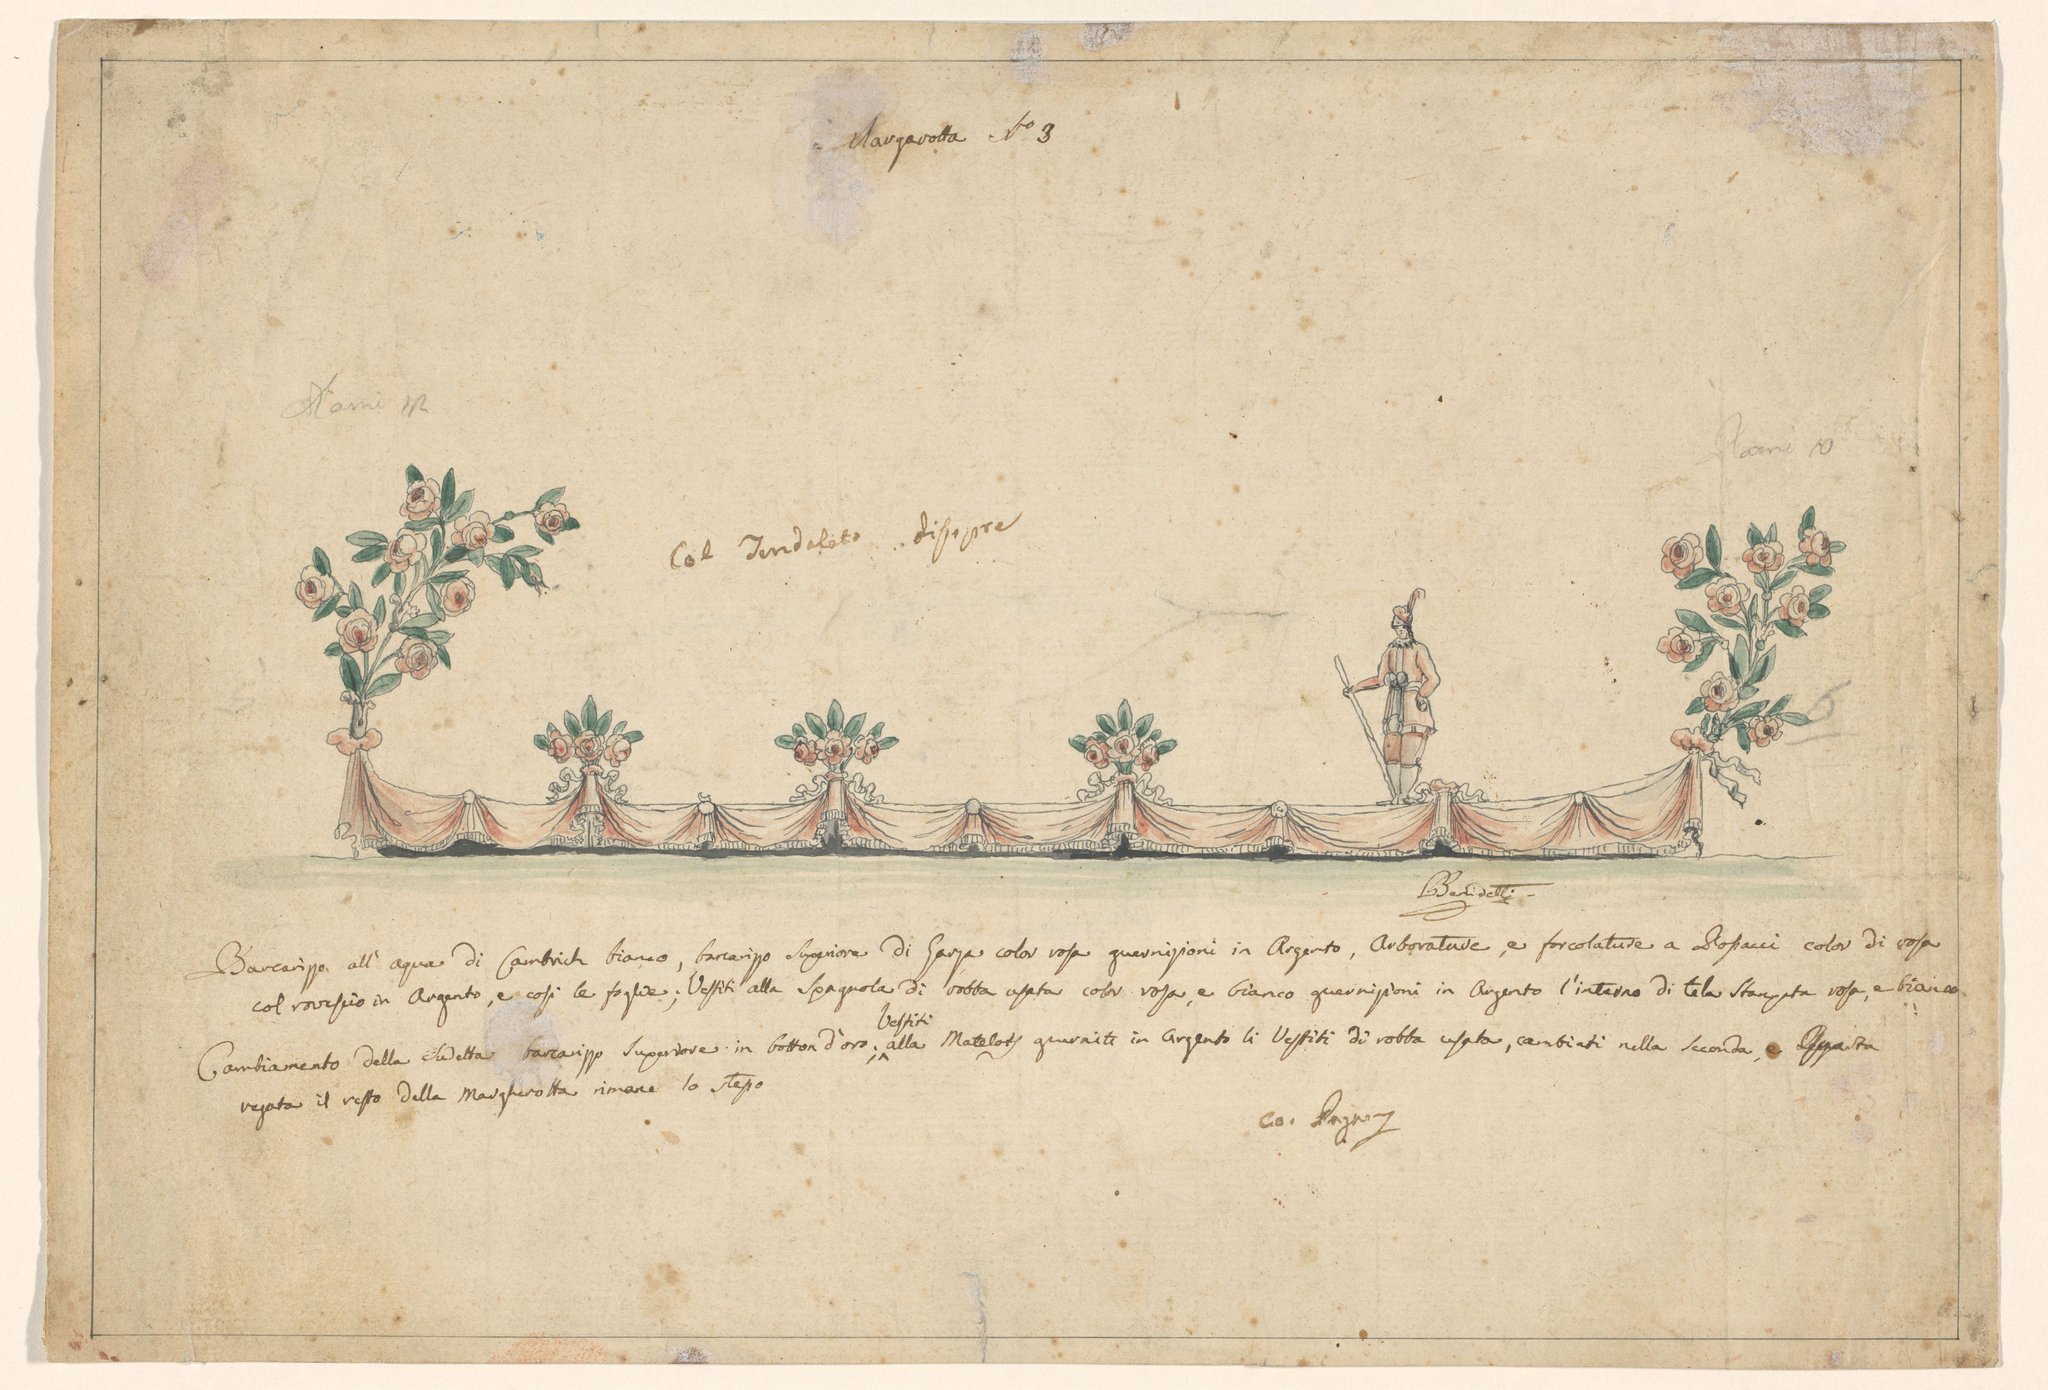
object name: print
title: Portret van Nicolas de La Fauconnière de Catinat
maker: Anonymous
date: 1667-1749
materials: paper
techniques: engraving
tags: historical persons, armorial bearing, heraldry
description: Onder het portret zijn wapenschild. Linksboven genummerd: 22.